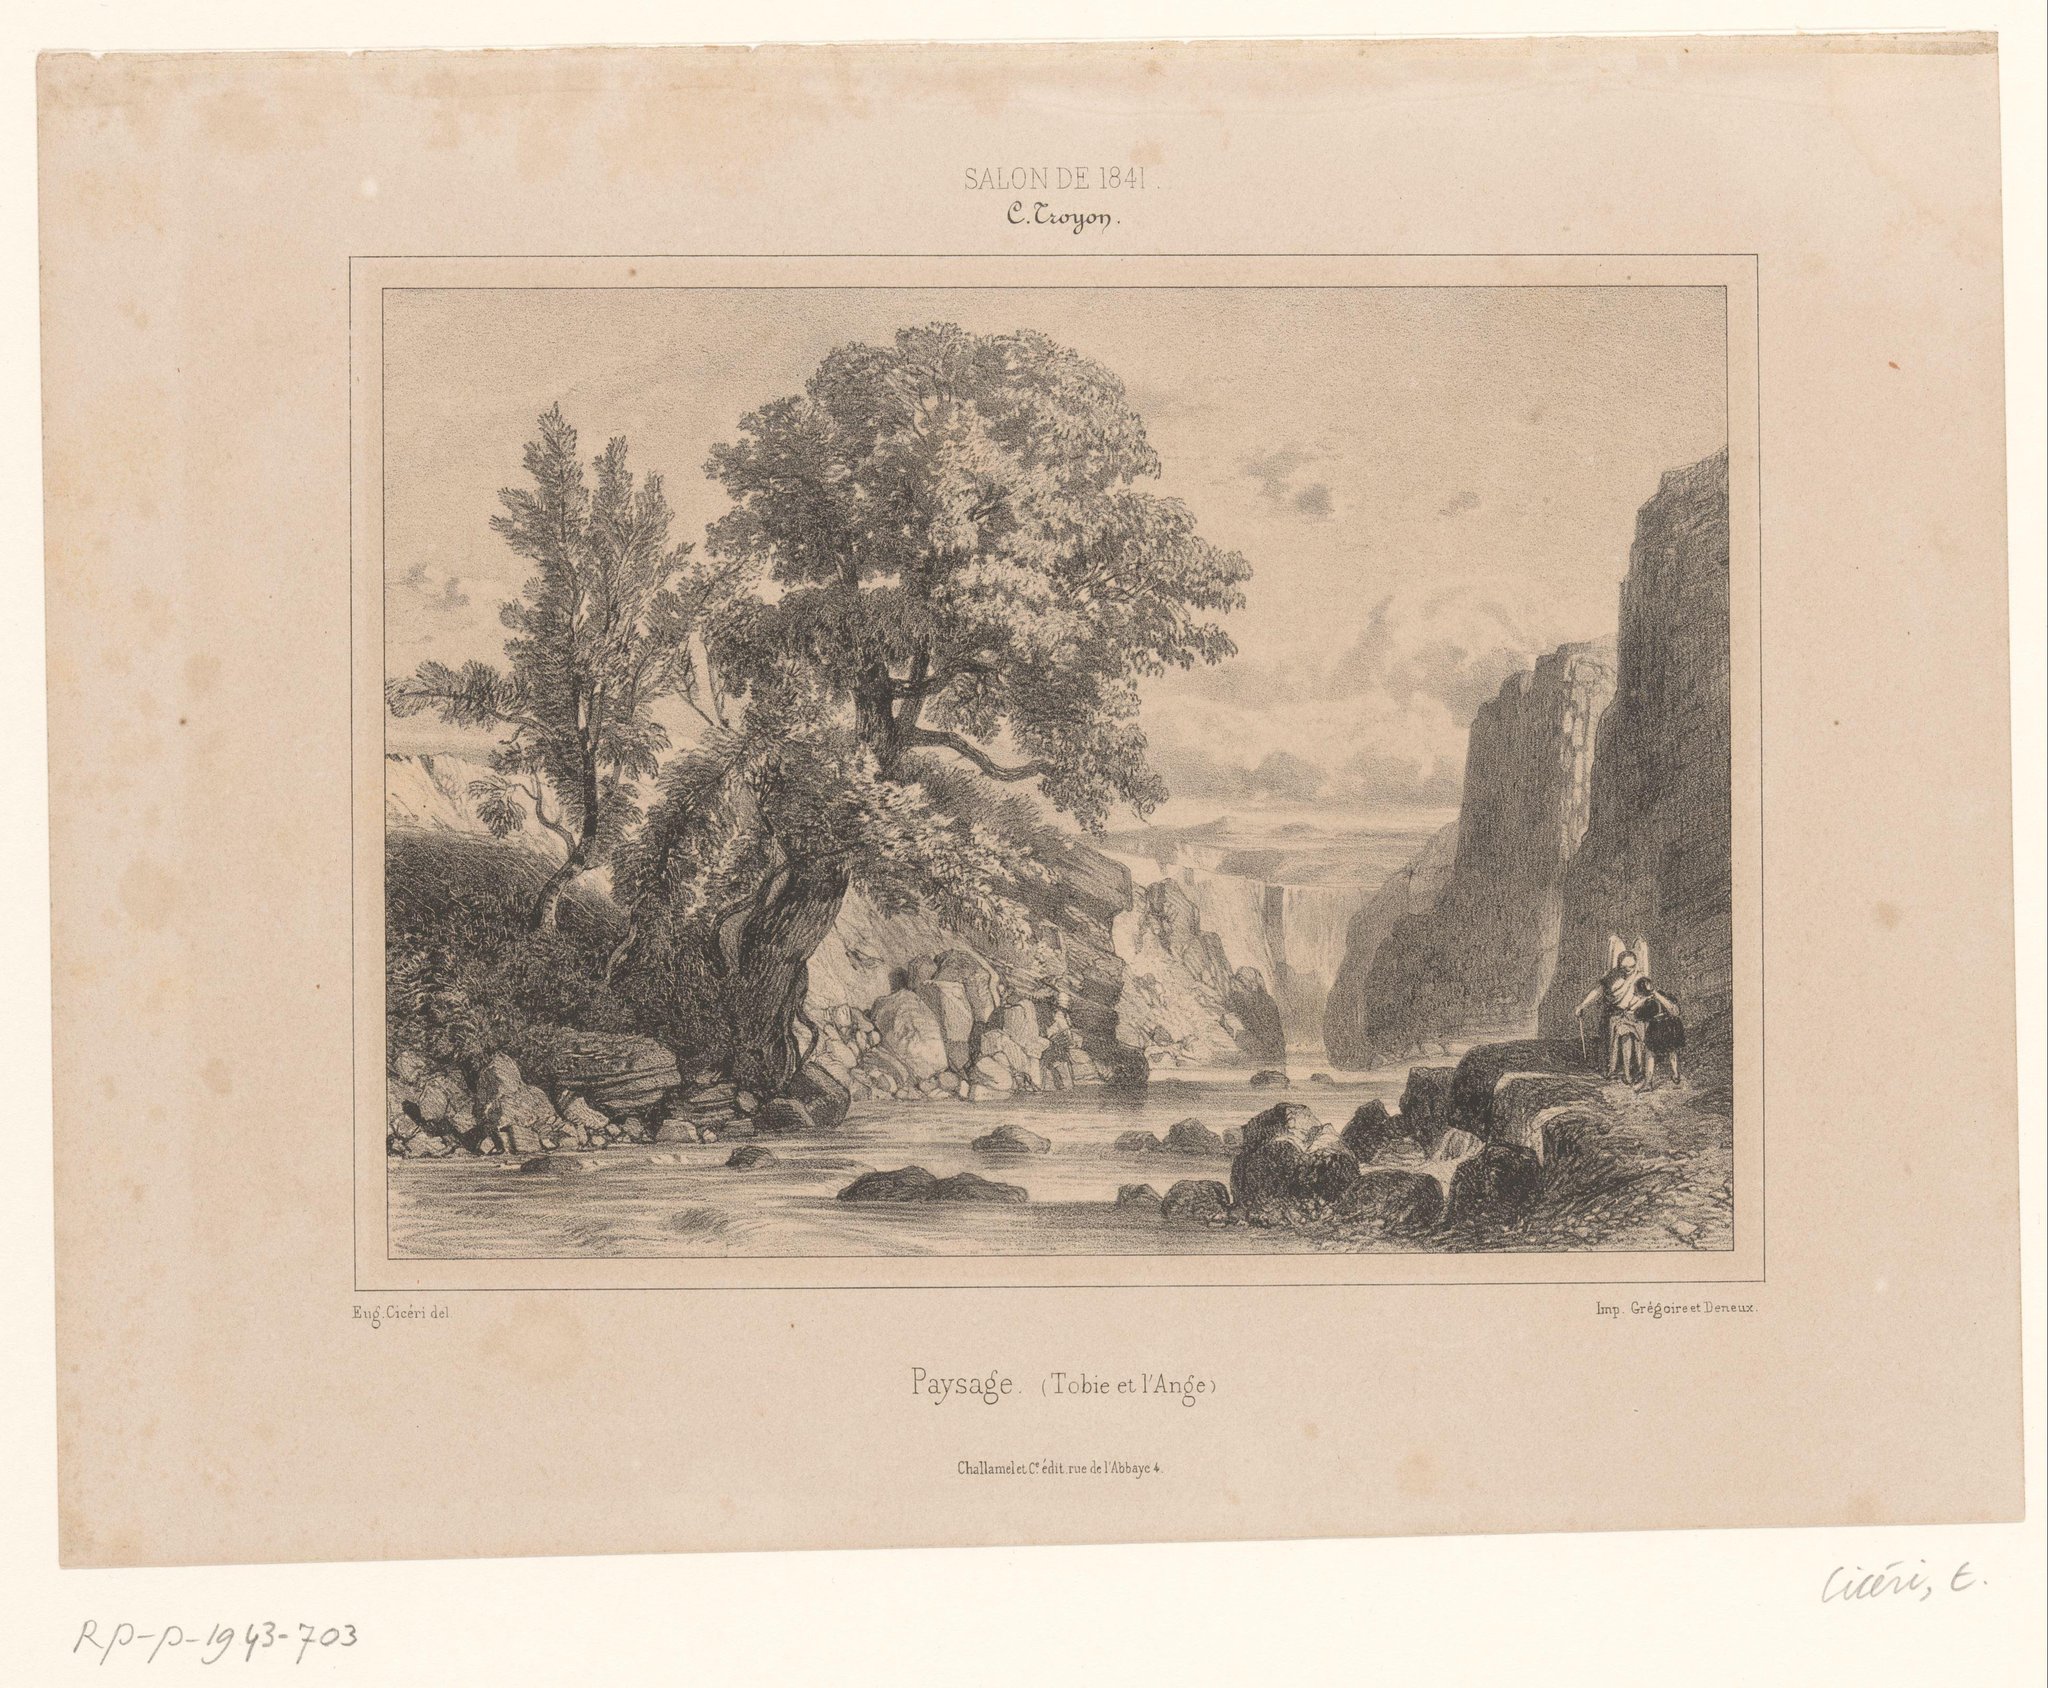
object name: print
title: Landschap met Tobias en de engel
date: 1841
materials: paper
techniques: lithograph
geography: paris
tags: tobias and the angel raphael travelling, accompanied by tobias' dog, rocks (+ landscape with figures, staffage), brook (+ landscape with figures, staffage)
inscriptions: collector's mark: Lugt 2228a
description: Prent gebruikt in: Ténint, Wilhelm. Album du Salon de 1841. Collection des principaux ouvrages exposés au Louvre (…). Parijs: Augustin Challamel, 1841.